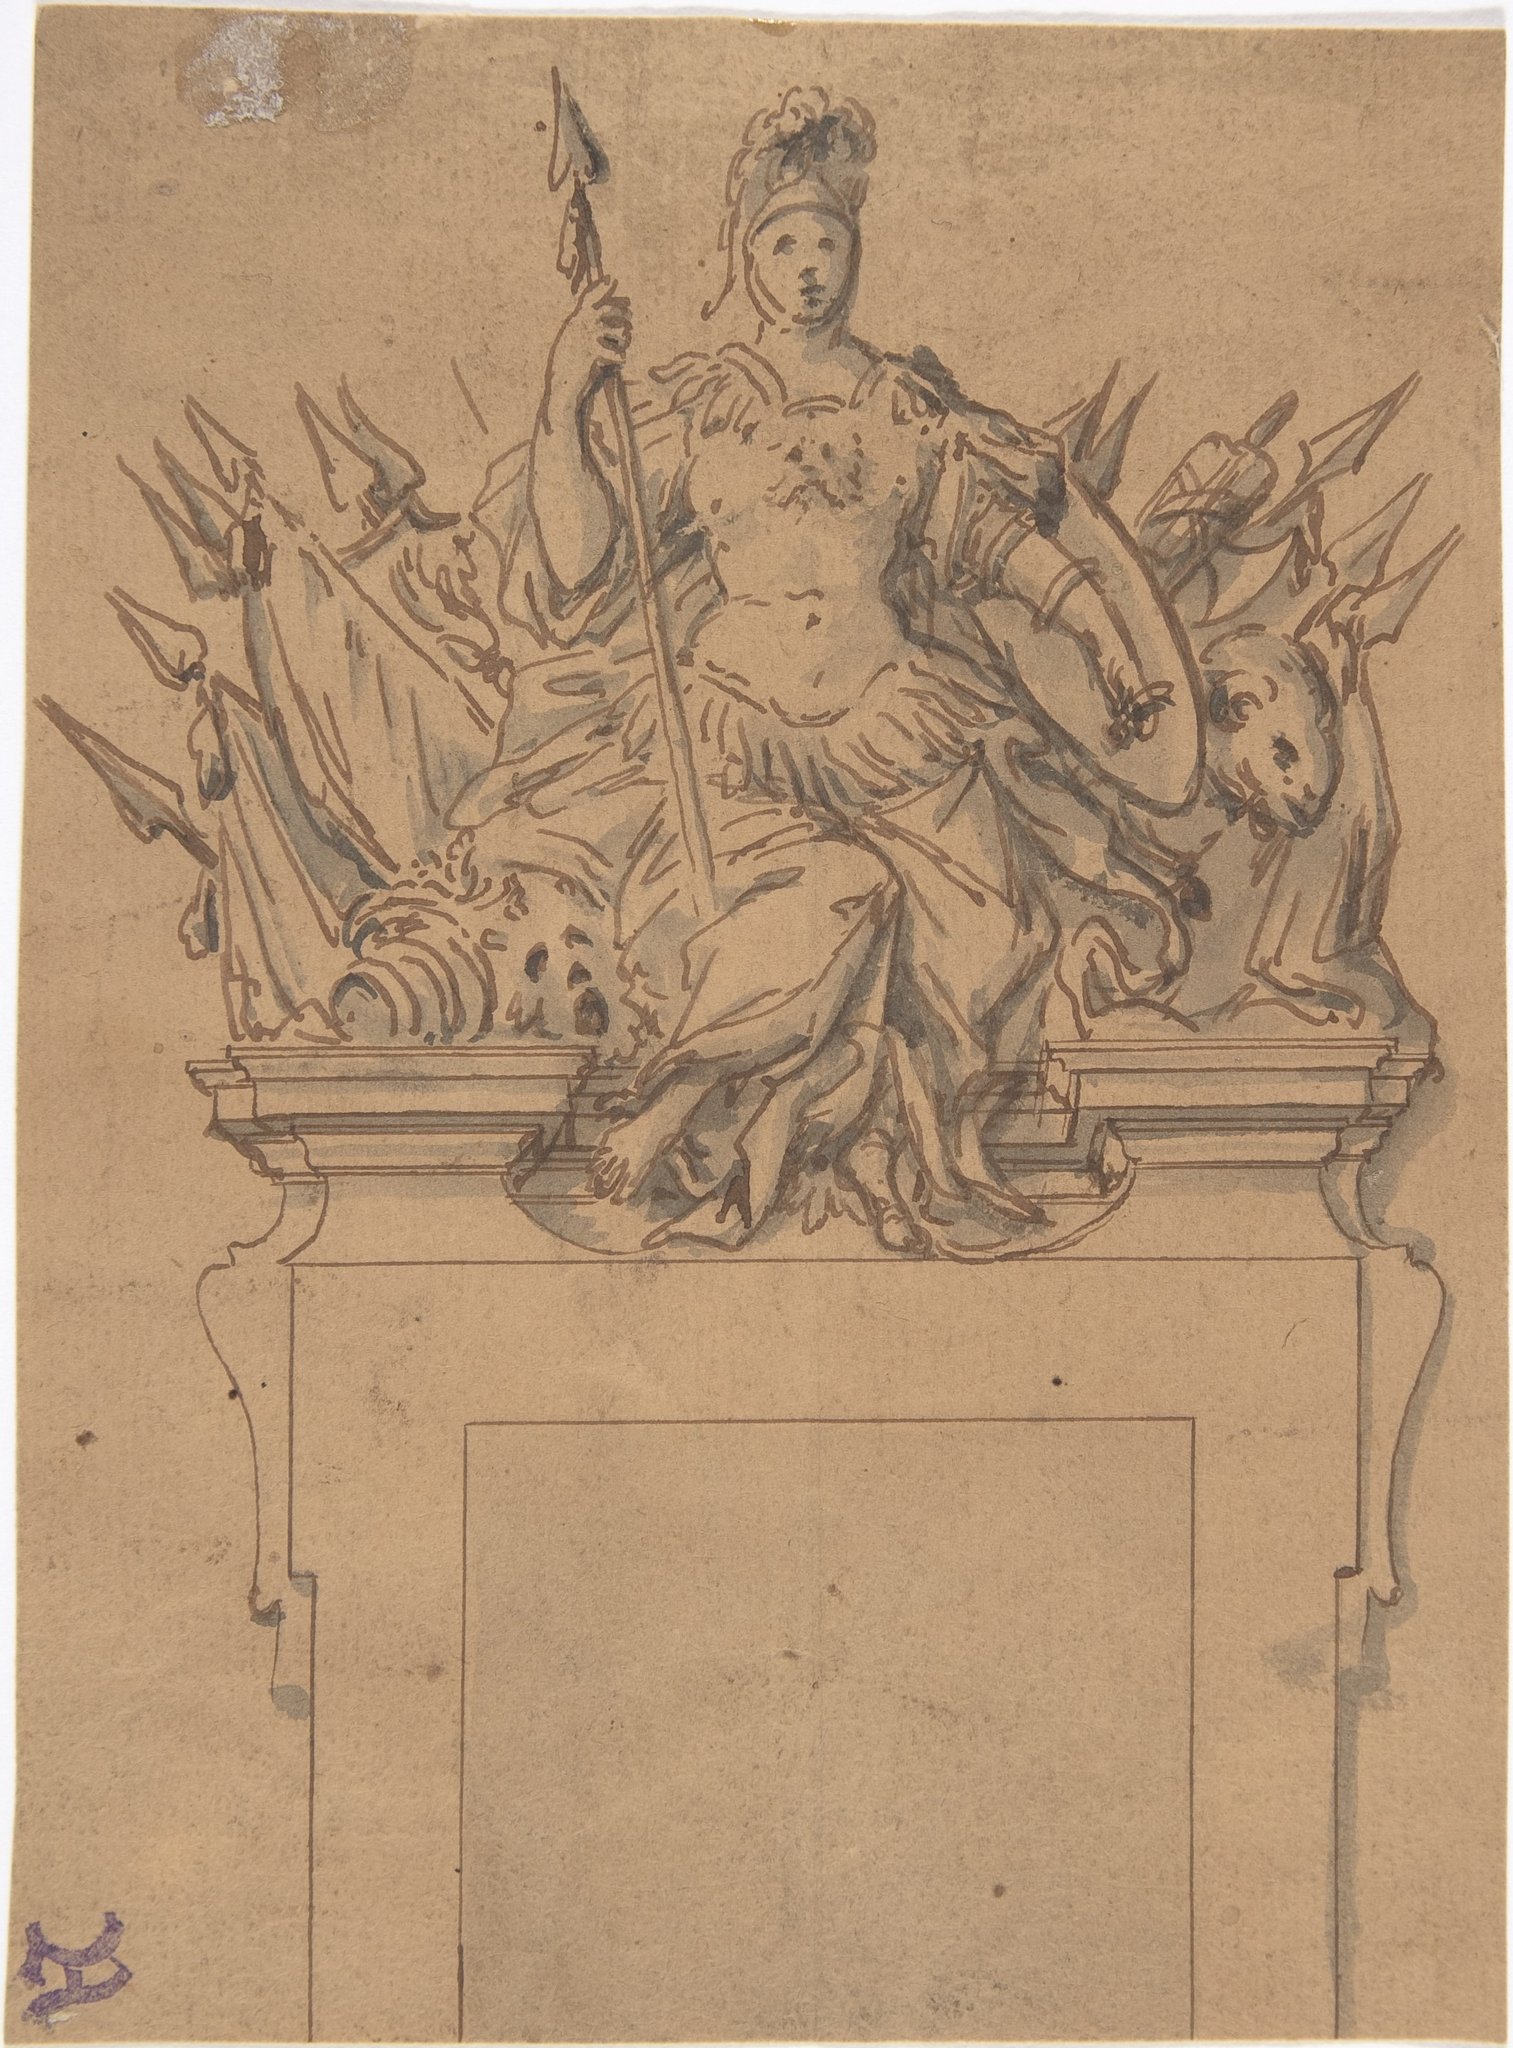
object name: drawing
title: Design for an Overdoor or Chimney Piece with an Armorial Trophy and the Figure of Minerva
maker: anonymous, french, 18th century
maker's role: artist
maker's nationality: french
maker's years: 1700-1800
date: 1701-1800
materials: ink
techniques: brush, pen, wash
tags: spears,minerva